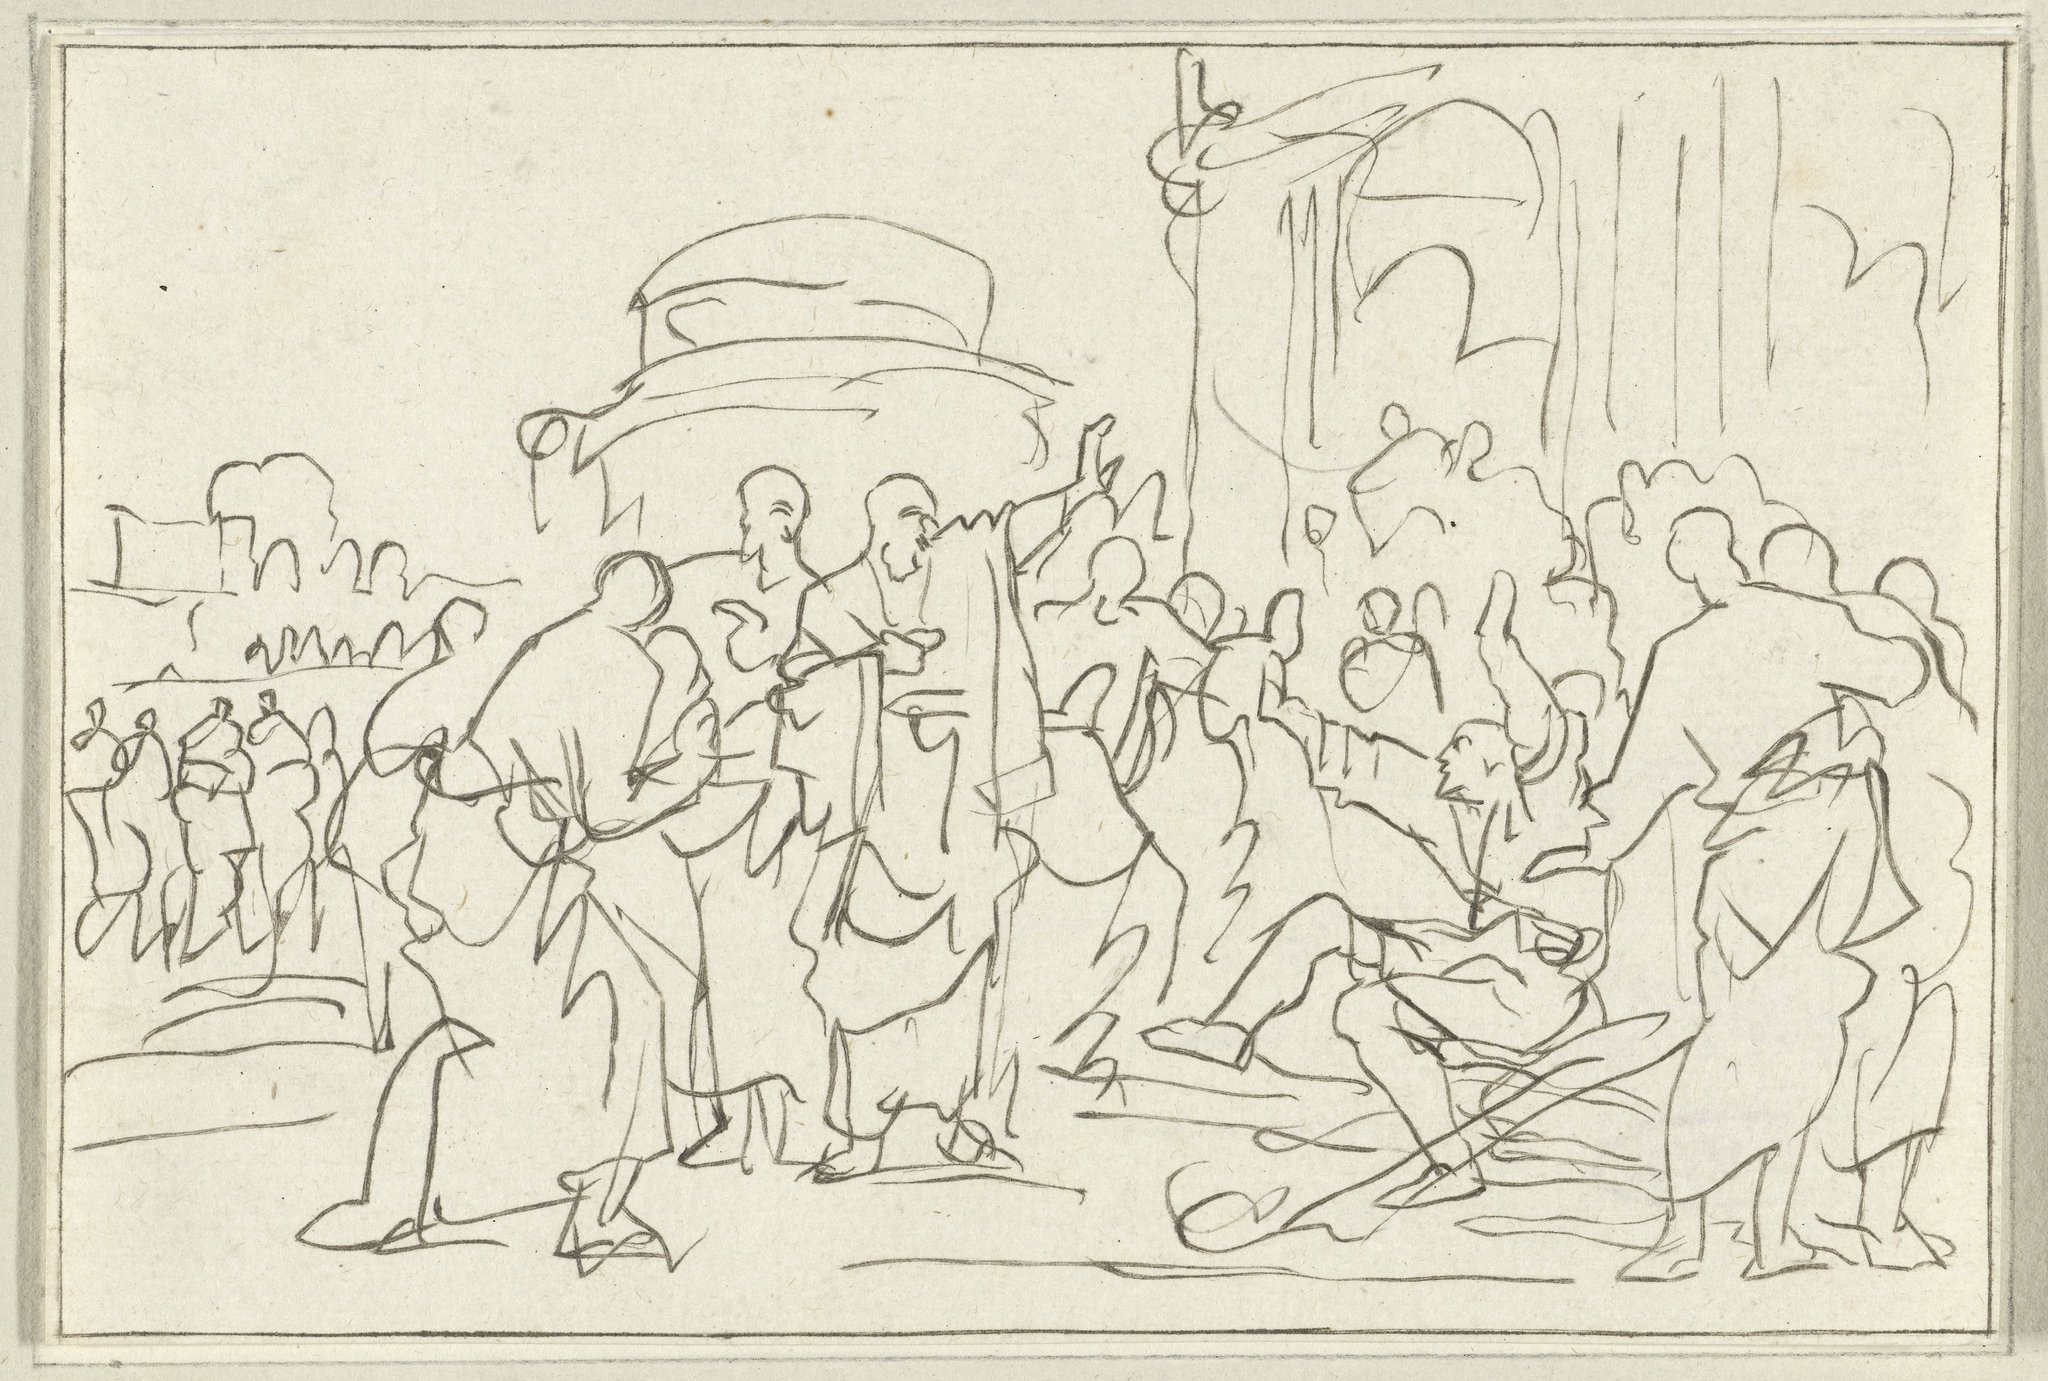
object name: print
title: Peter and John heal a paralyzed man at the temple gate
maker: benjamin martini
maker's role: print maker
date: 1777-1780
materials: paper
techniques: etching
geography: amsterdam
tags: healing of a lame beggar at the beautiful gate of the temple by peter and john (acts 3 - 4:31)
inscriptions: inscription: ‘Op proefdrukken met vollen plaatrand staat de naam van Martini als vervaardiger van deze prenttekening’, collector's mark: Lugt 2228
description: De voorstelling is gebaseerd op de tekst uit Handelingen 3:4-31. In de Statenvertaling is de bedelaar beschreven als: “En een zeker man, die kreupel was van zijner moeders lijf, werd gedragen, welken zij dagelijks zetten aan de deur des tempels (…) Maar Petrus zei (…) In den Naam van Jezus Christus den Nazaréner, sta op en wandel. En hem grijpende bij de rechterhand, richtte hij hem op, en terstond werden zijn voeten en enkels vast”. In de Nieuwe Bijbelvertaling wordt er niet gesproken over ‘kreupel’ maar over verlamming: “Men had ook een man die al sinds zijn geboorte verlamd was naar de tempel gebracht (…) Maar Petrus zei (…) in de naam van Jezus Christus van Nazareth, sta op en loop.’ Hij pakte hem bij zijn rechterhand om hem overeind te helpen. Onmiddellijk kwam er kracht in zijn voeten en enkels.”